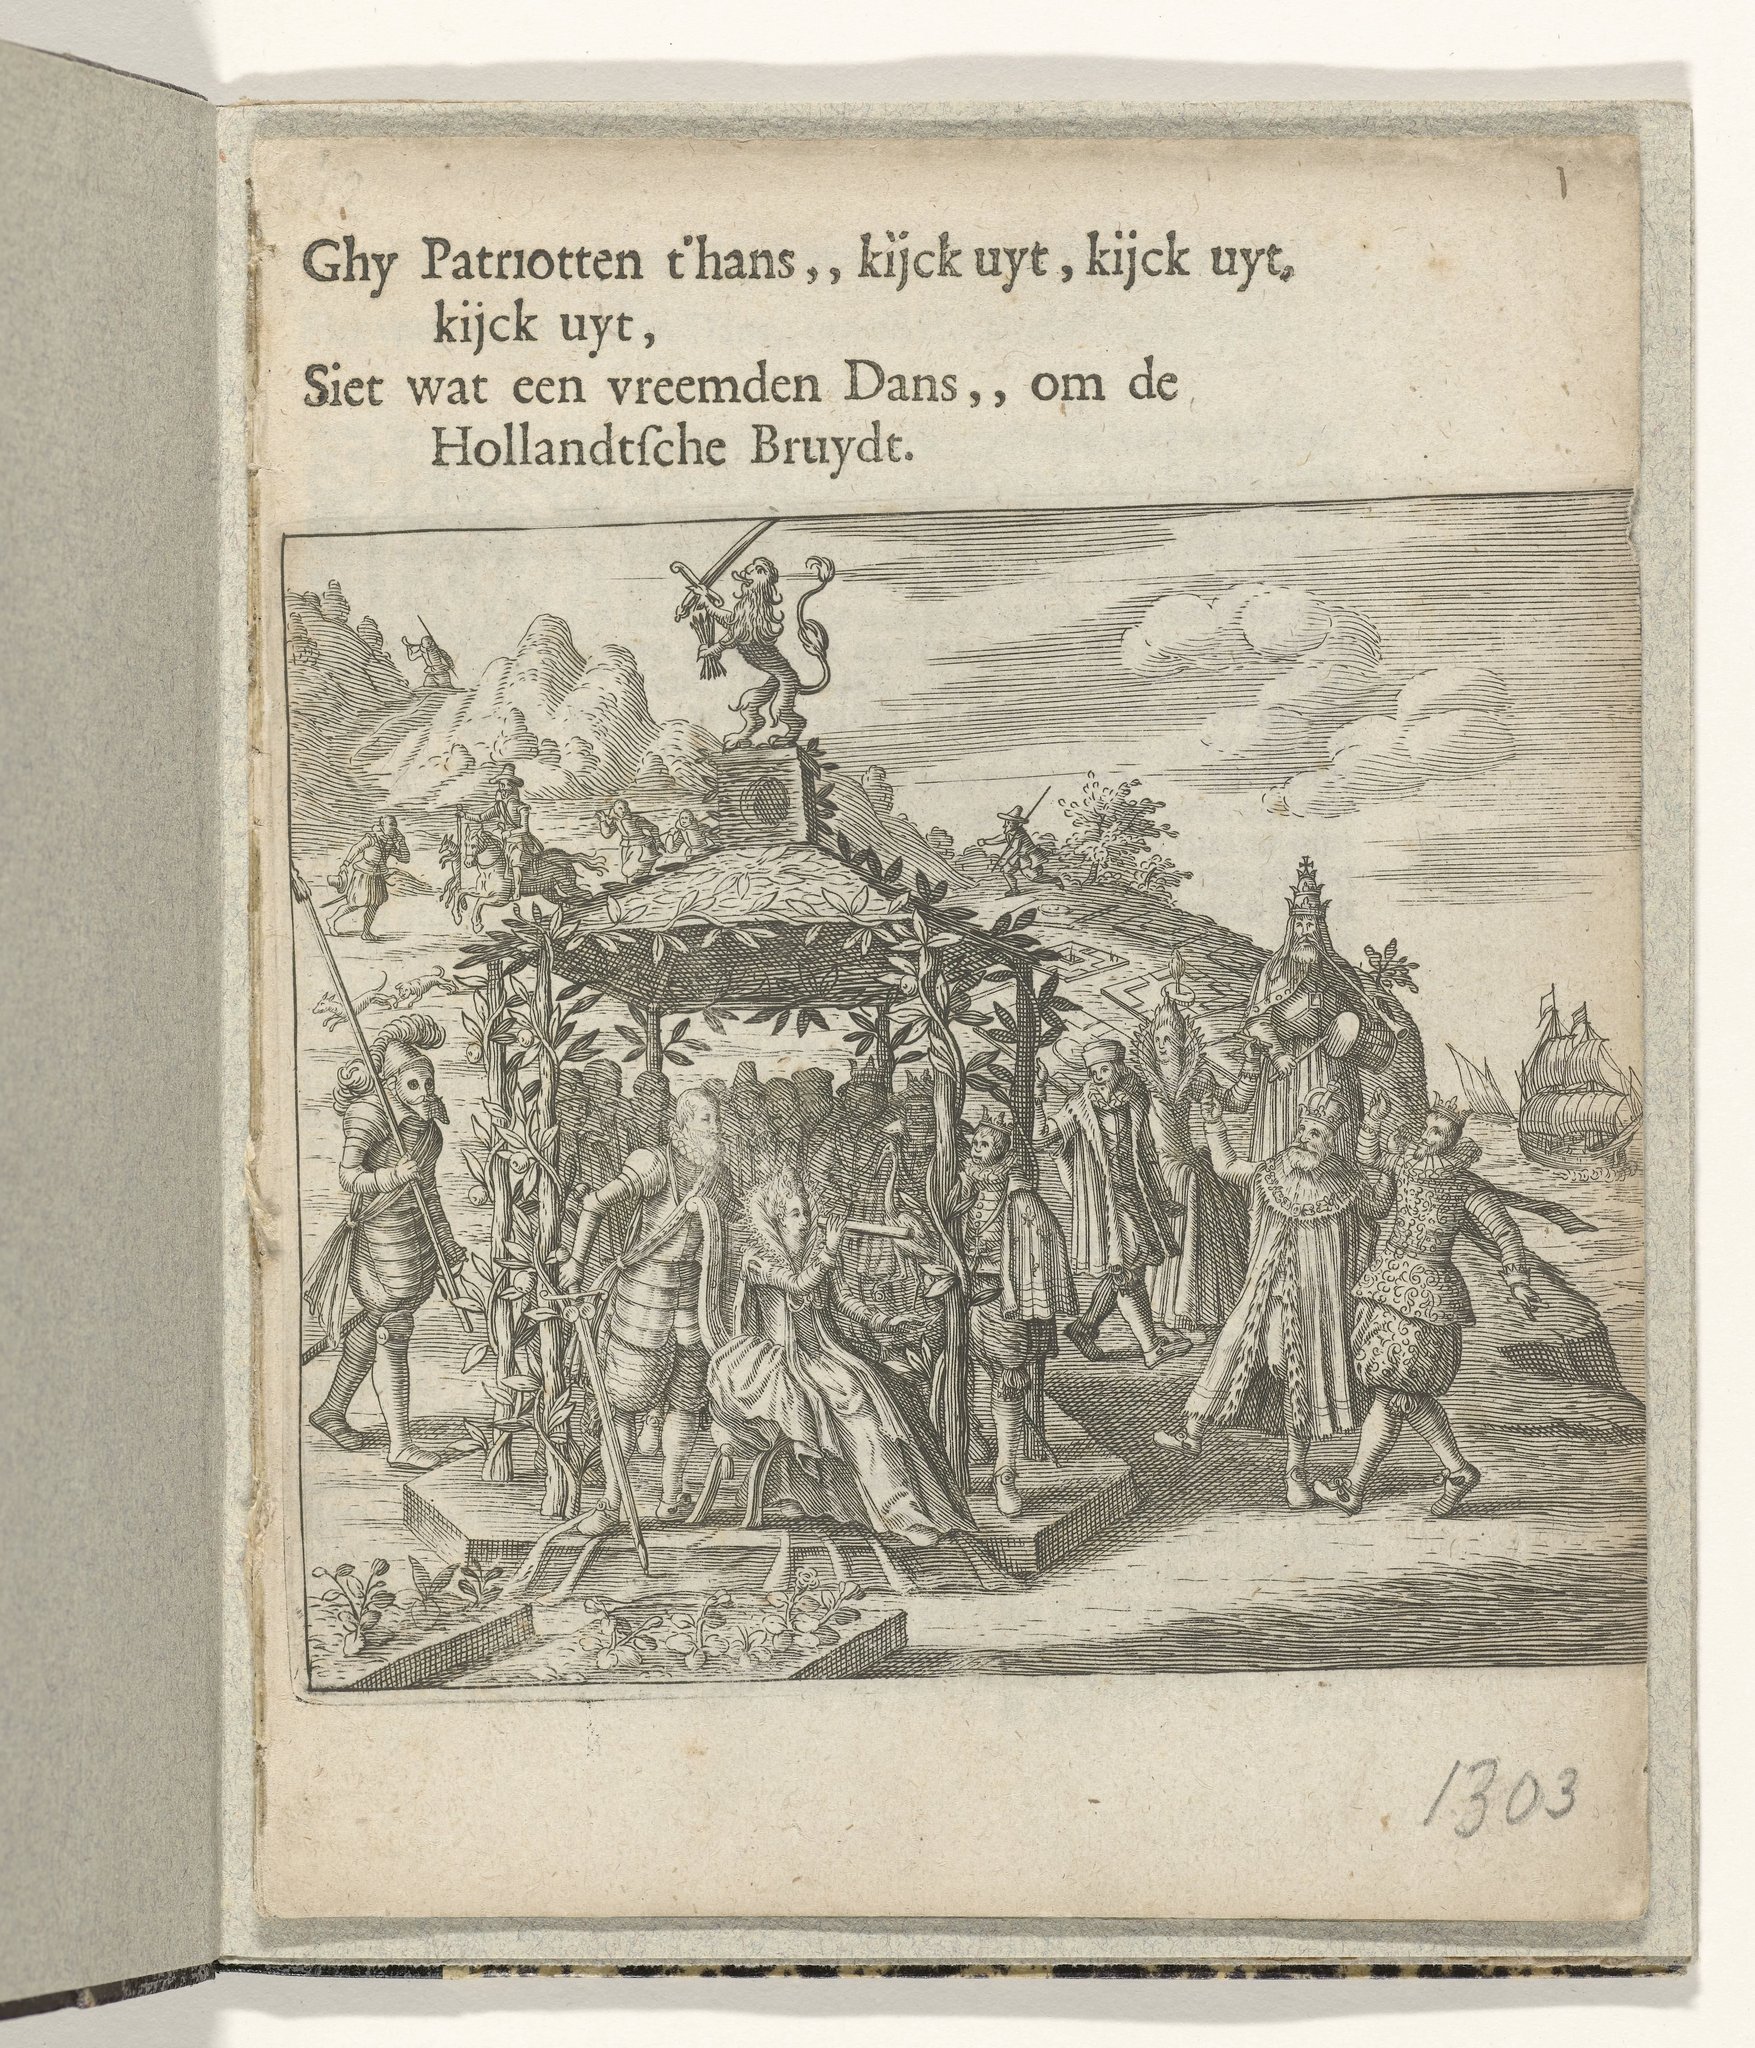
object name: titelblad, titelpagina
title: Titelblad van het pamflet Ghy Patriotten t'hans, kijck uyt, kijck uyt, kijck uyt, Siet wat een vreemden Dans, om de Hollandtsche Bruydt, 1615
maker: Anonymous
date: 1615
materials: paper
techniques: engraving, letterpress printing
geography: northern netherlands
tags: maurice (prince of orange), infante van spanje isabella clara eugenia, albrecht aartshertog van oostenrijk, personifications of countries, nations, states, districts, etc., fenced or walled garden; 'hortus conclusus', netherlands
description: Titelblad van het pamflet Ghy Patriotten t'hans, kijck uyt, kijck uyt, kijck uyt, Siet wat een vreemden Dans, om de Hollandtsche Bruydt, 1615. Allegorie op de situatie in de Nederlanden in het jaar 1615 met een oproep om waakzaam te blijven. De Nederlandse Maagd (Belgica) zit in een prieel versierd met ranken waaraan appels (van Oranje) groeien. Zij heeft een verrekijker in een hand en een kraanvogel in de andere hand. Achter haar staat prins Maurits met getrokken zwaard. Rechts dansen aartshertog Albrecht en Isabella, de keizer en de koning van Spanje naar het pijpen en trommelen van de paus.